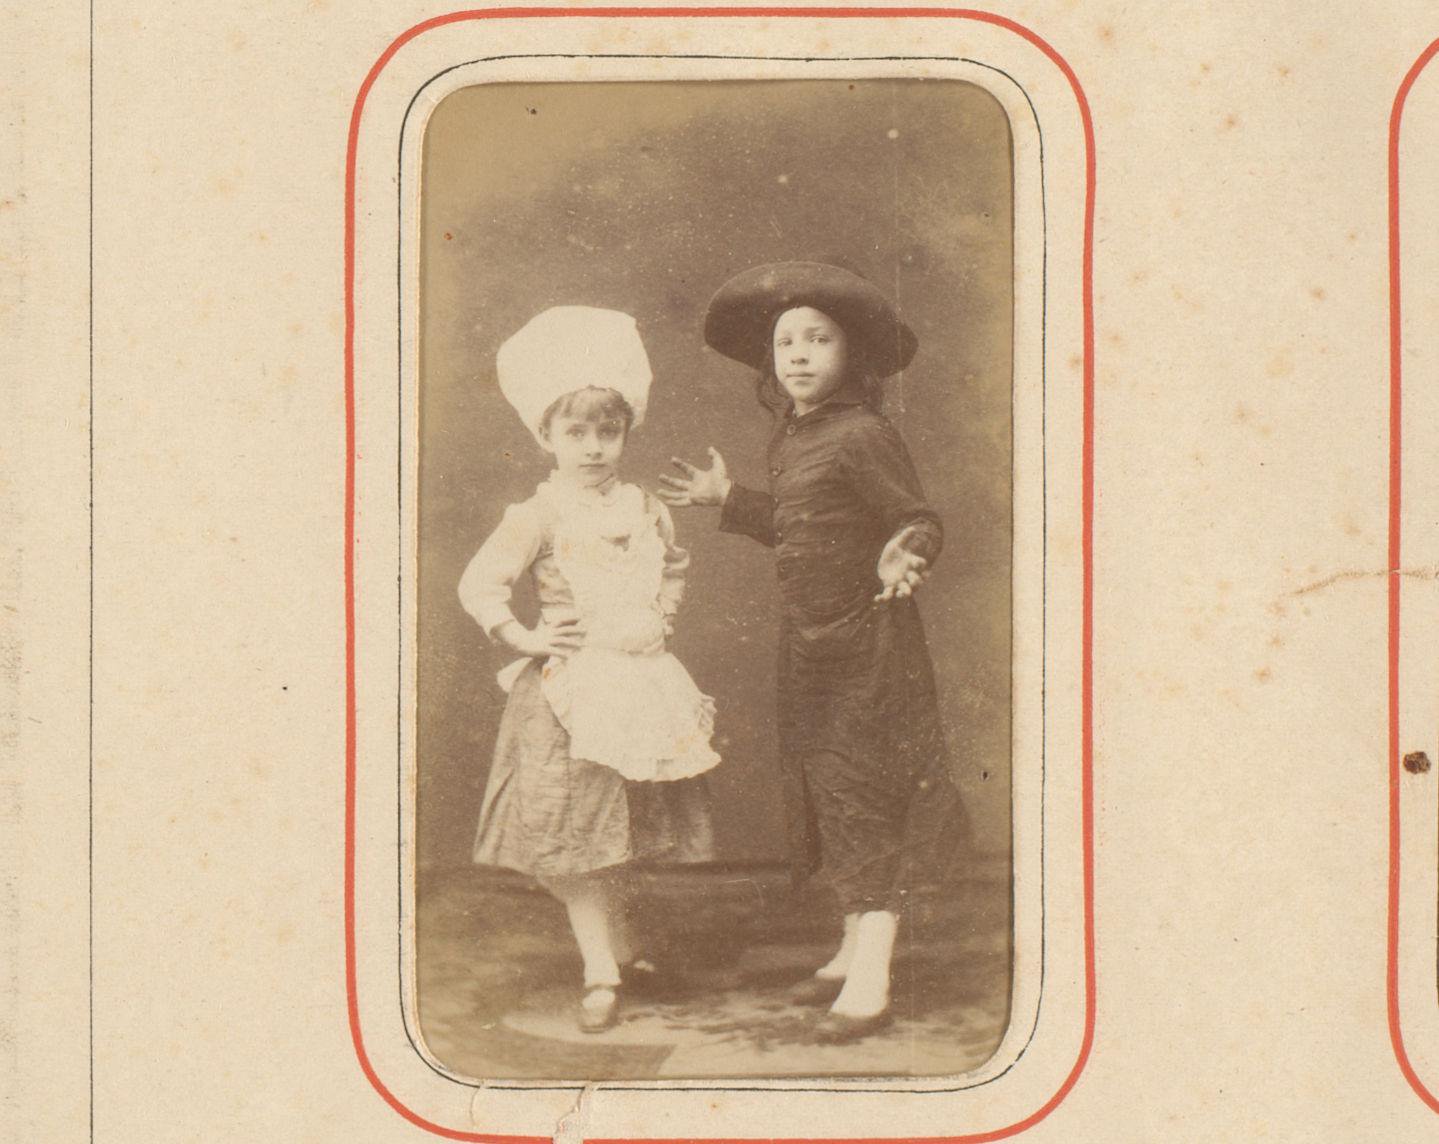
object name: carte de visite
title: Portret van een onbekende jongen en meisje in verkleedkleren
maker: alexandre leroux (fotograaf)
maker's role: fotograaf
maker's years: 1836-1912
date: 1875-1890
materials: cardboard, paper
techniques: albumen print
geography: algiers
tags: anonymous historical persons portrayed in a double portrait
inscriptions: address: ‘9. Rue de la Lyre.’